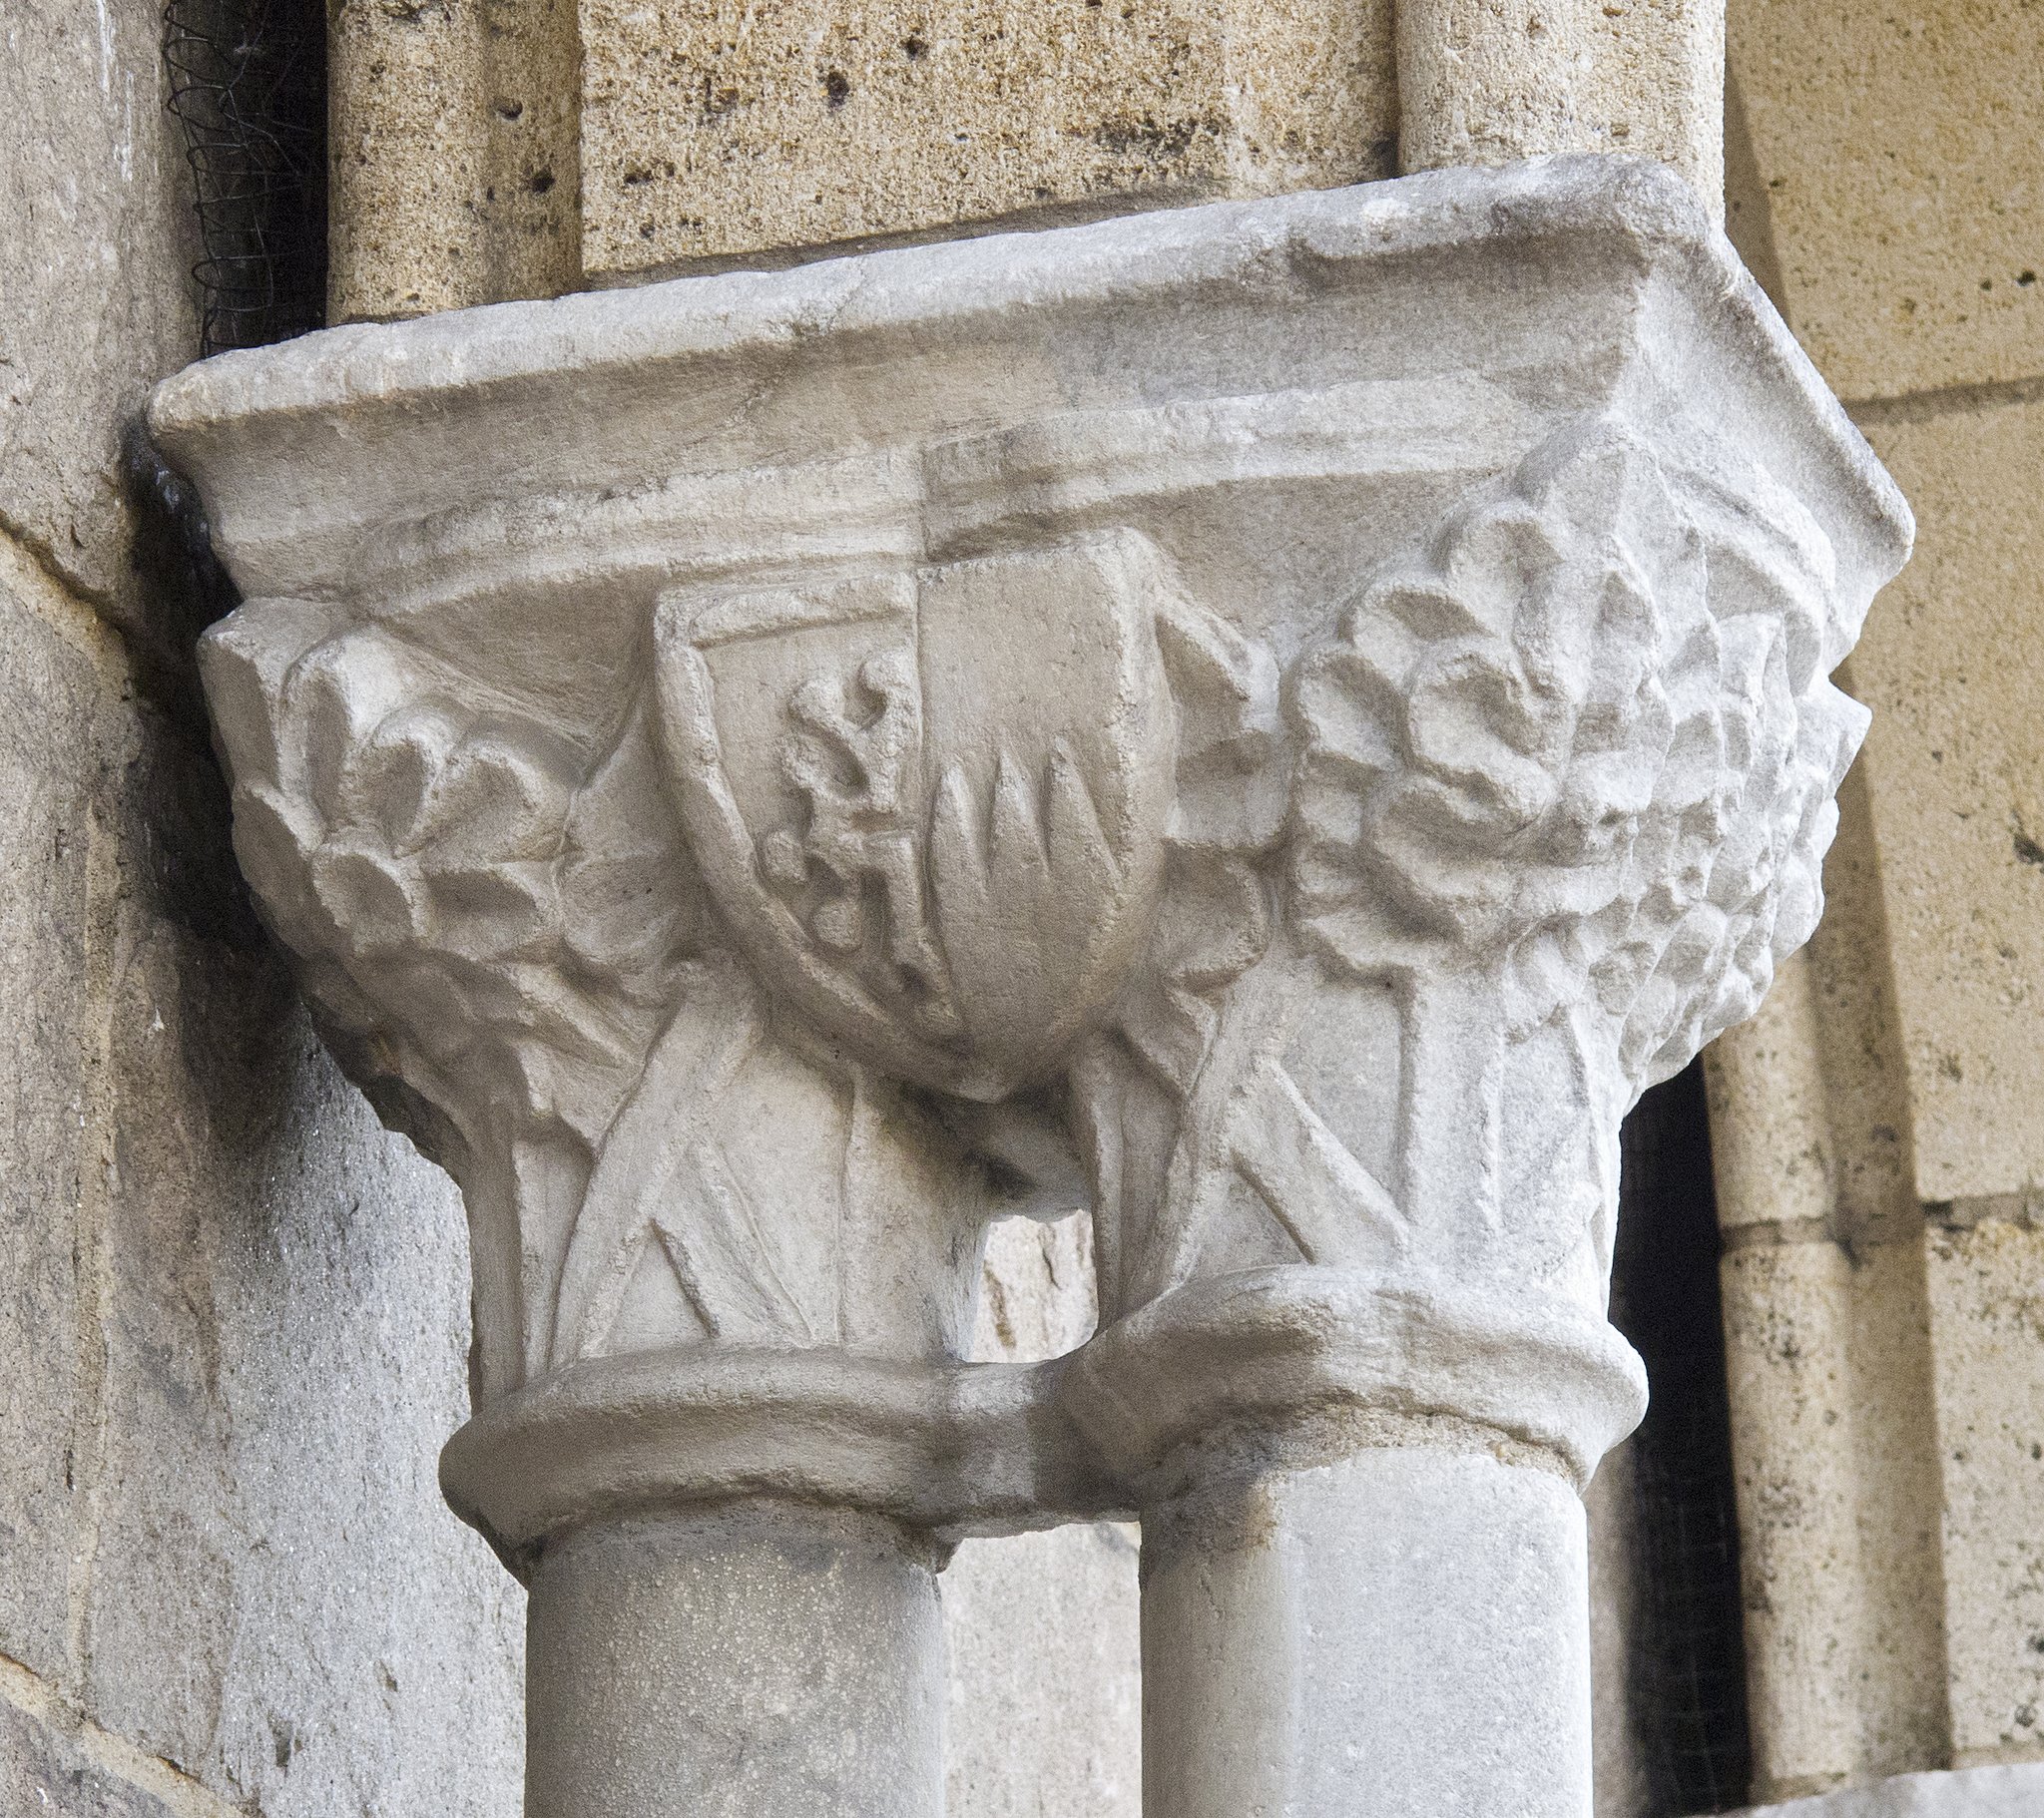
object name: capital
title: Cloister Arcades with Double Capitals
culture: french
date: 1267-1333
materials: marble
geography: france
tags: coat of arms